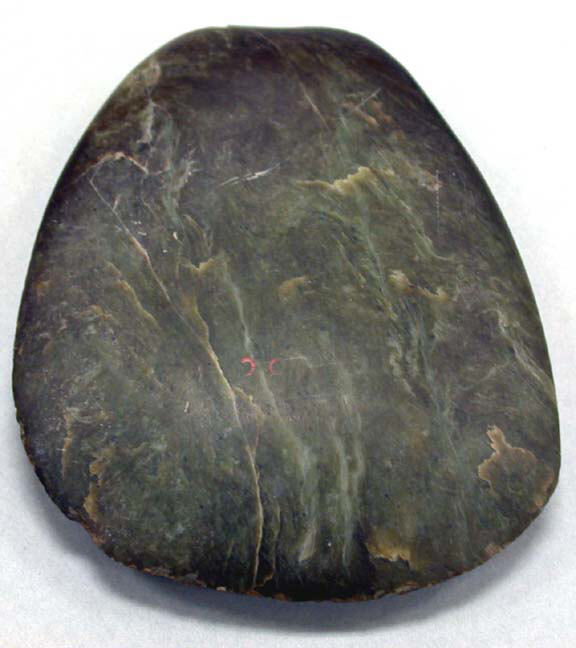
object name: axe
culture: new zealander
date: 1902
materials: jade